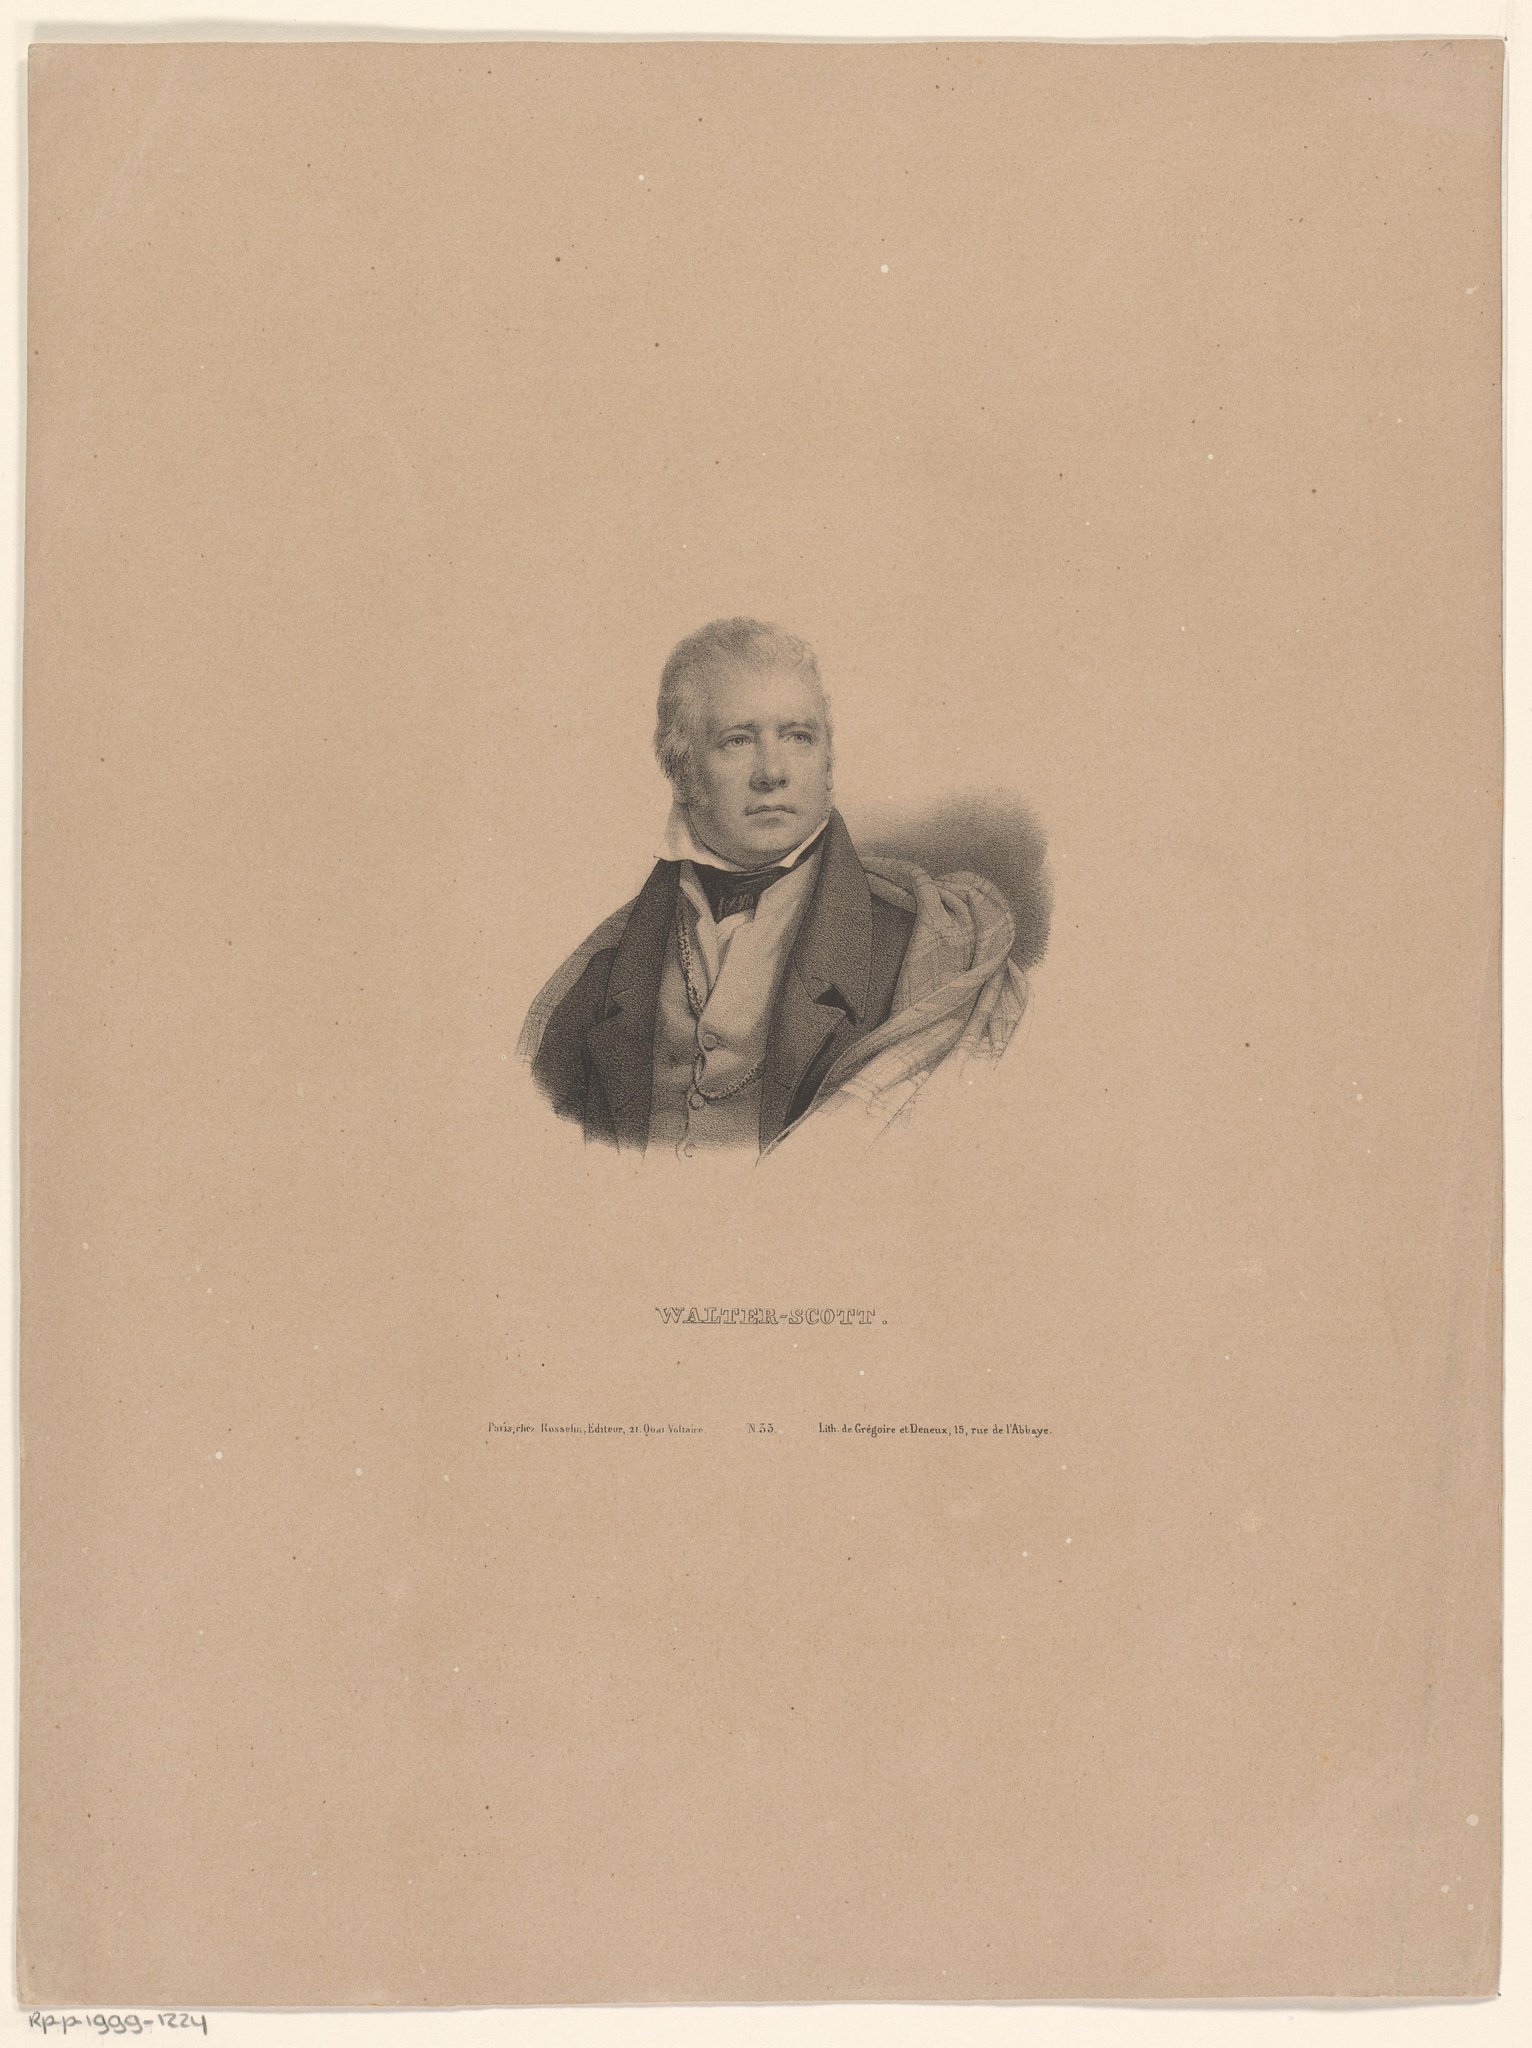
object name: print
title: Portret van Walter Scott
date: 1835-1851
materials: paper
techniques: lithograph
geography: paris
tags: walter scott, historical persons, portrait of a writer, writer, poet, author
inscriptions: collector's mark: Lugt 2228, collector's mark: Lugt 2760